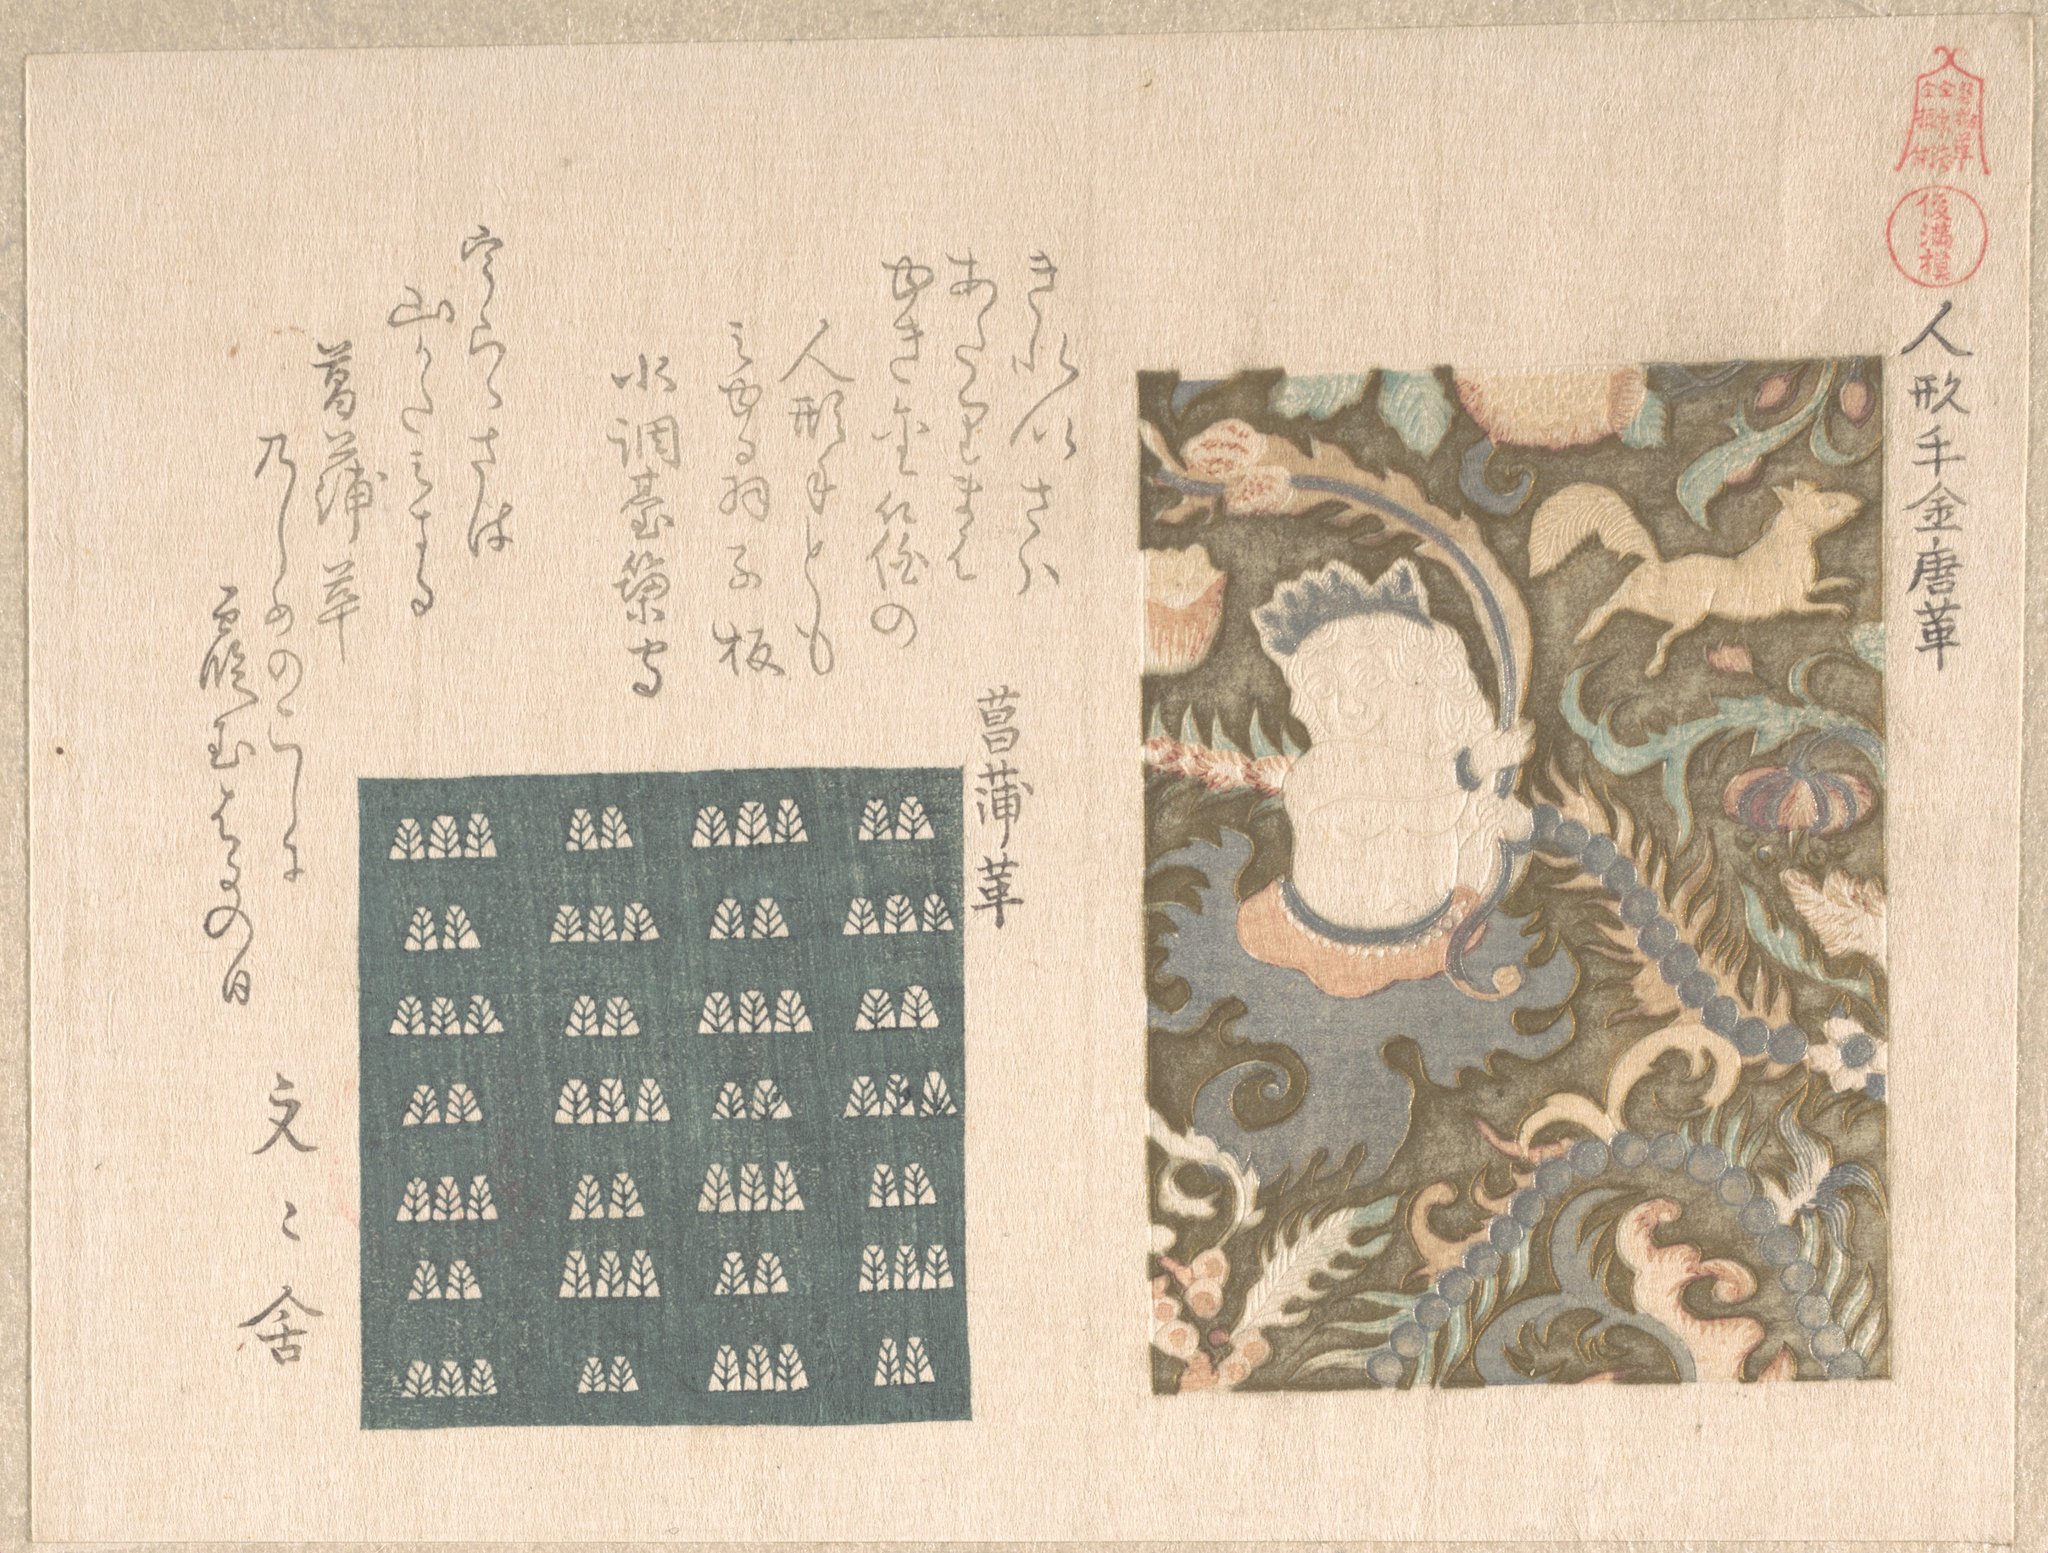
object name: print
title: “Gold-decorated Leather with Figure of a Chinese Boy” and “Patterned Leather,” from the series Famous Leathers, Inrō, and Netsuke Meibutsu kawa, inrō, netsuke) From the Spring Rain Collection (Harusame shū), vol. 2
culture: japanese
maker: kubo shunman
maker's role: artist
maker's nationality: japanese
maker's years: 1757-1820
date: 1810-1819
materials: ink, paper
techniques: surimono, woodblock print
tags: animals,boys